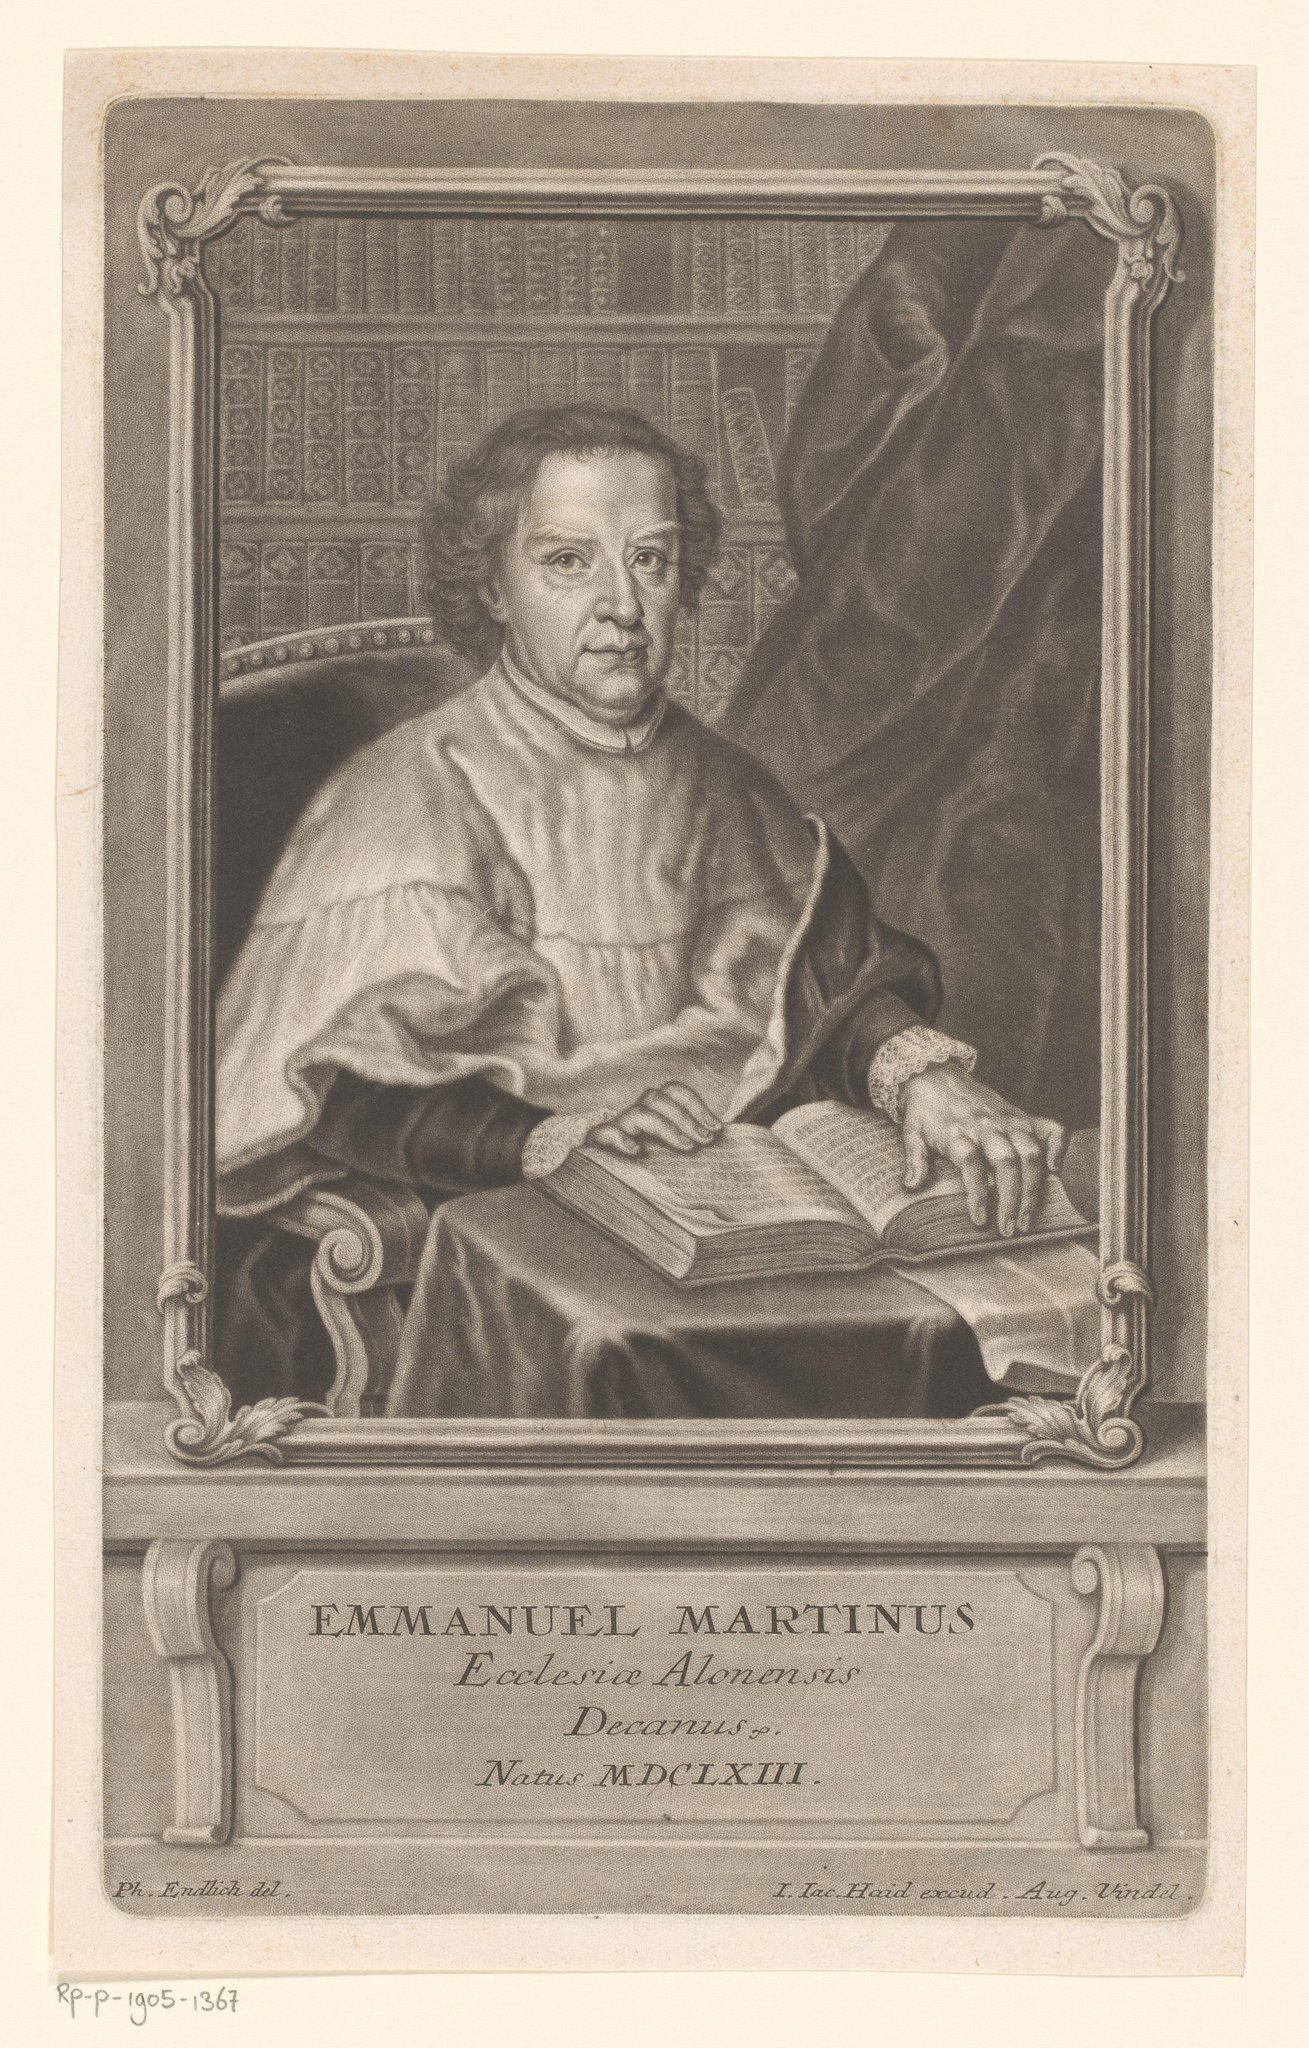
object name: print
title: Portret van Manuel Martinez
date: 1741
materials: paper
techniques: mezzotint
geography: augsburg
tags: bookshelves, historical persons, portrait of a writer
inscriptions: collector's mark: Lugt 2228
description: Prent gebruikt voor: Brucker, Jacob. Bildersal heutiges Tages lebender und durch Gelahrheit berühmter Schrifftsteller. Augsburg: Johann Jacob Haid, 1741.